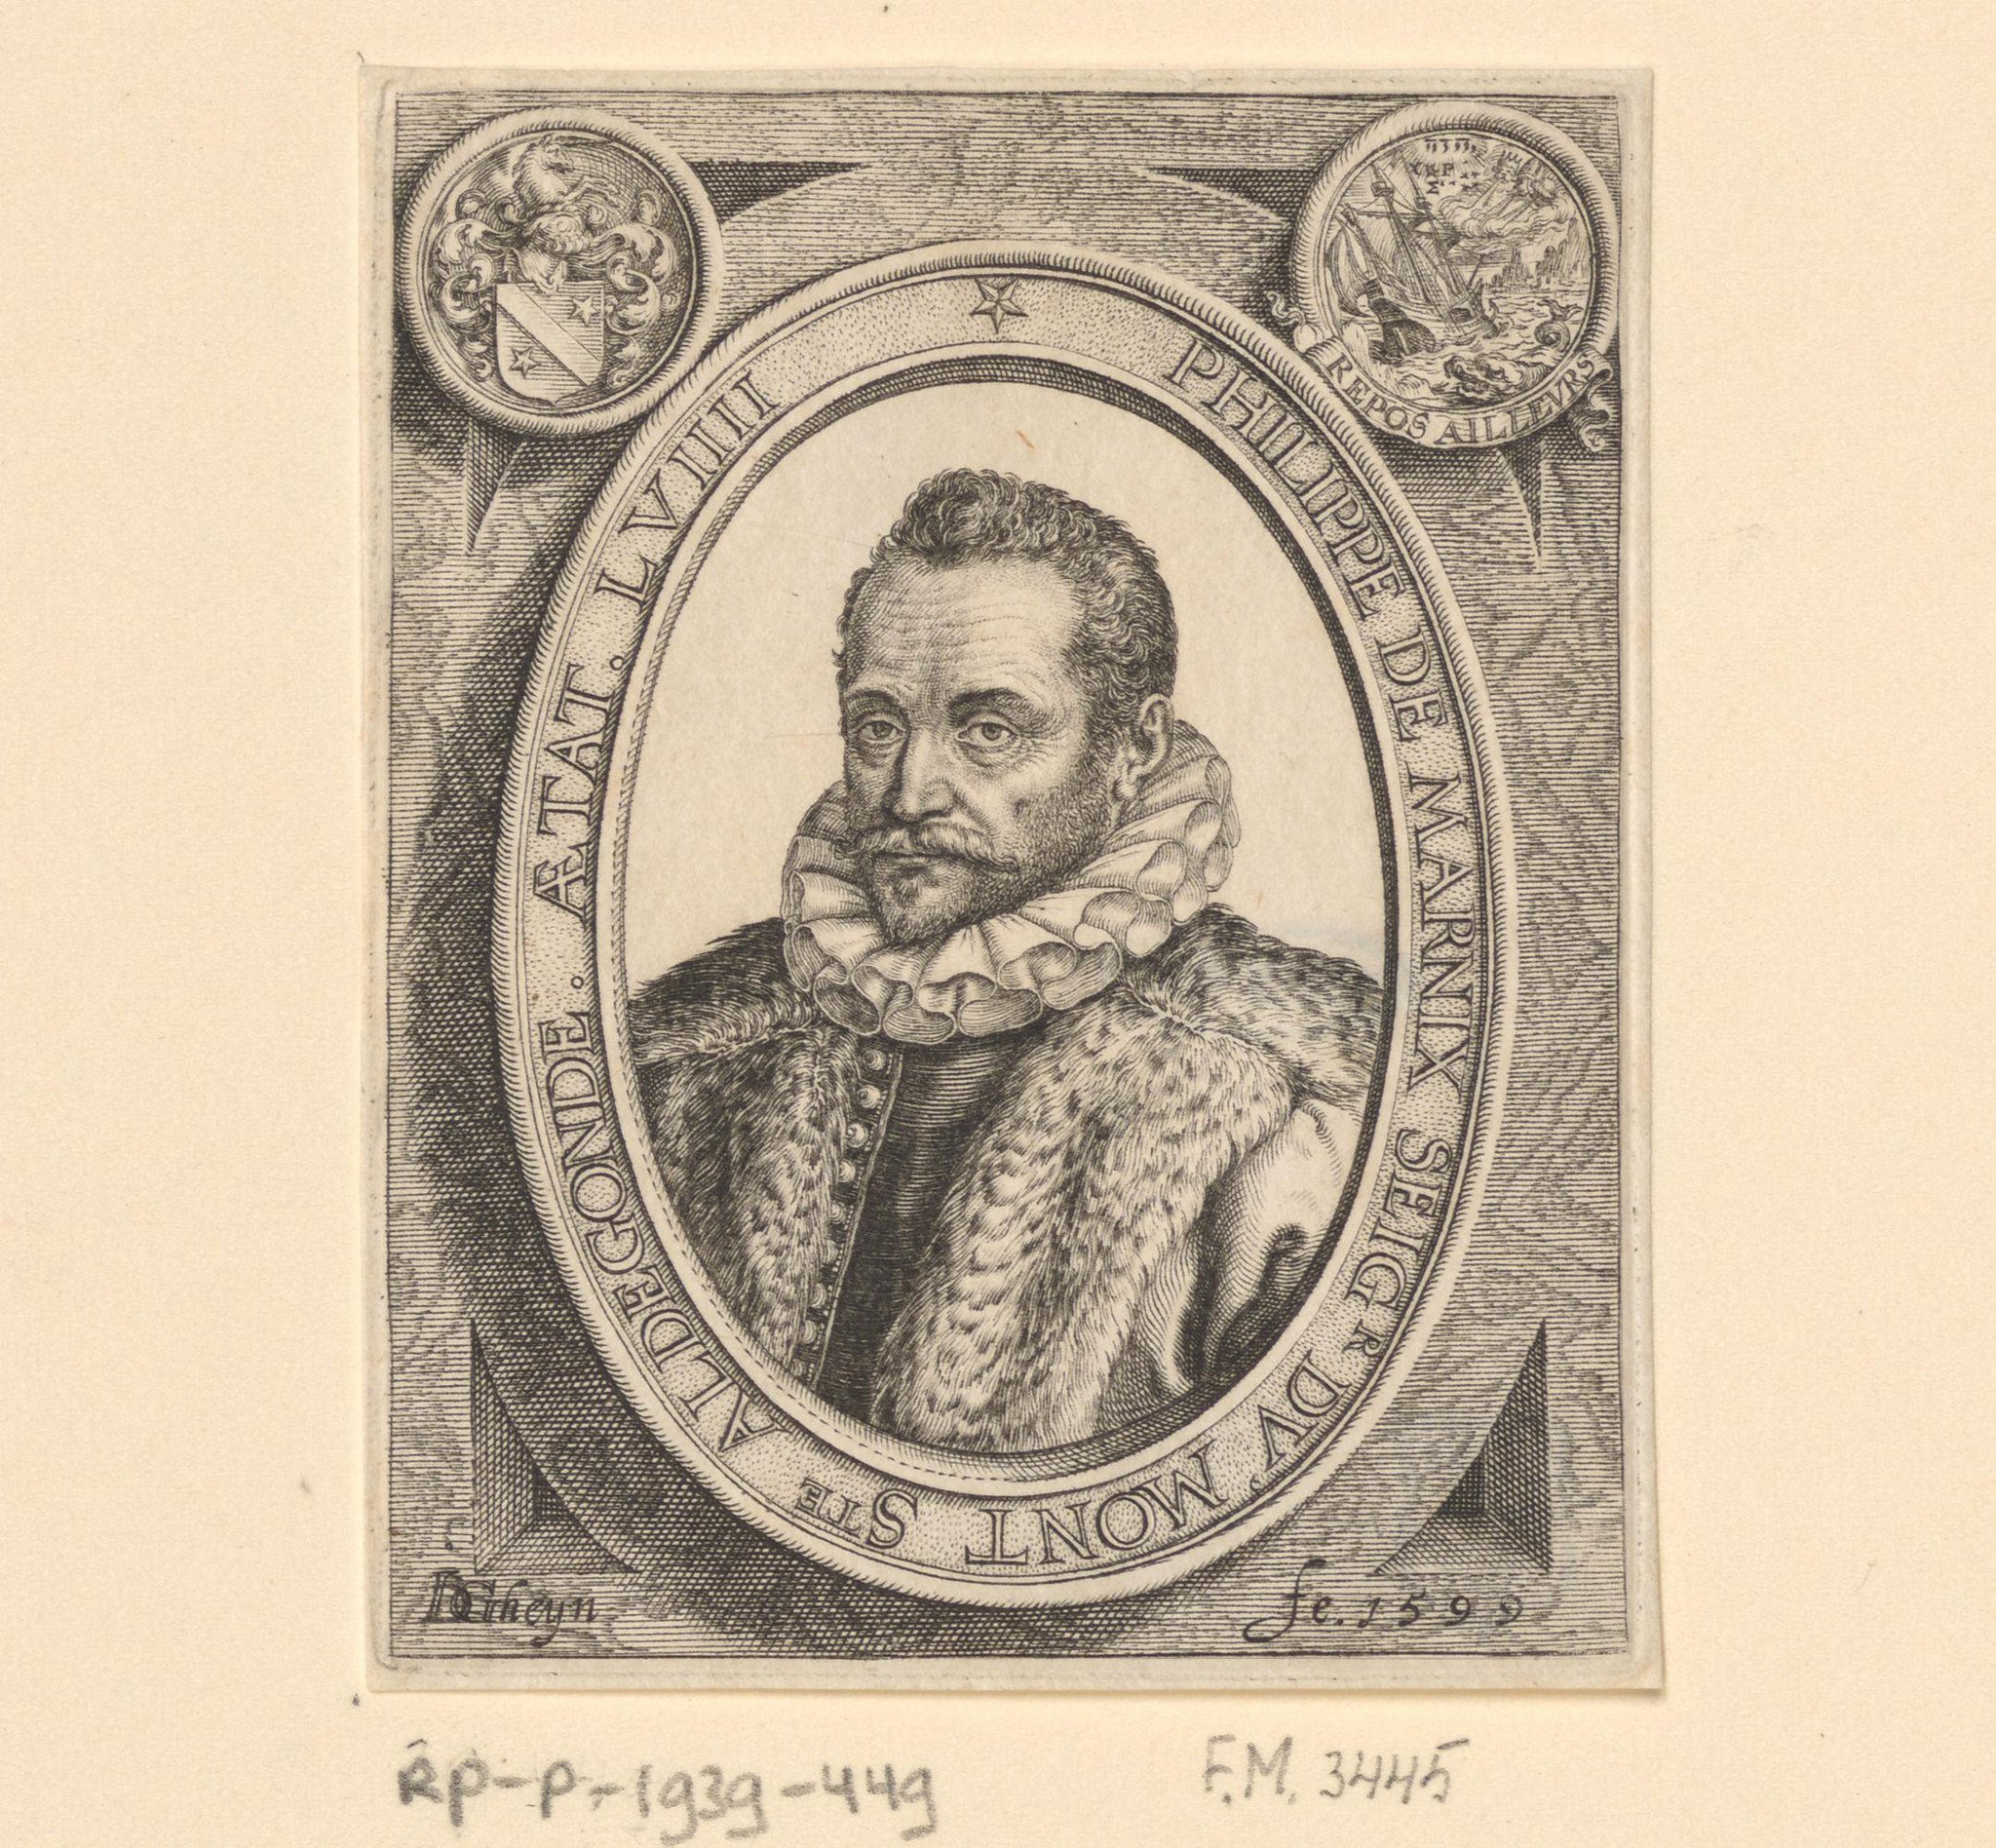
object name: print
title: Portret van Filips van Marnix van Sint-Aldegonde op 59-jarige leeftijd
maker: jacques de gheyn (ii)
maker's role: painter, print maker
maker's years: 1565-1629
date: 1599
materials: paper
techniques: engraving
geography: northern netherlands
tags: politician, filips van marnix van sint-aldegonde, ornament ~ medallion, historical persons, portrait of a writer, politician, e.g. party leader, armorial bearing, heraldry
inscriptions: collector's mark: Lugt 963, collector's mark: Lugt 2228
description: Filips van Marnix van Sint-Aldegonde overleed in 1598 en was toen waarschijnlijk 58 jaar oud, en niet 59 zoals op de prent vermeld.